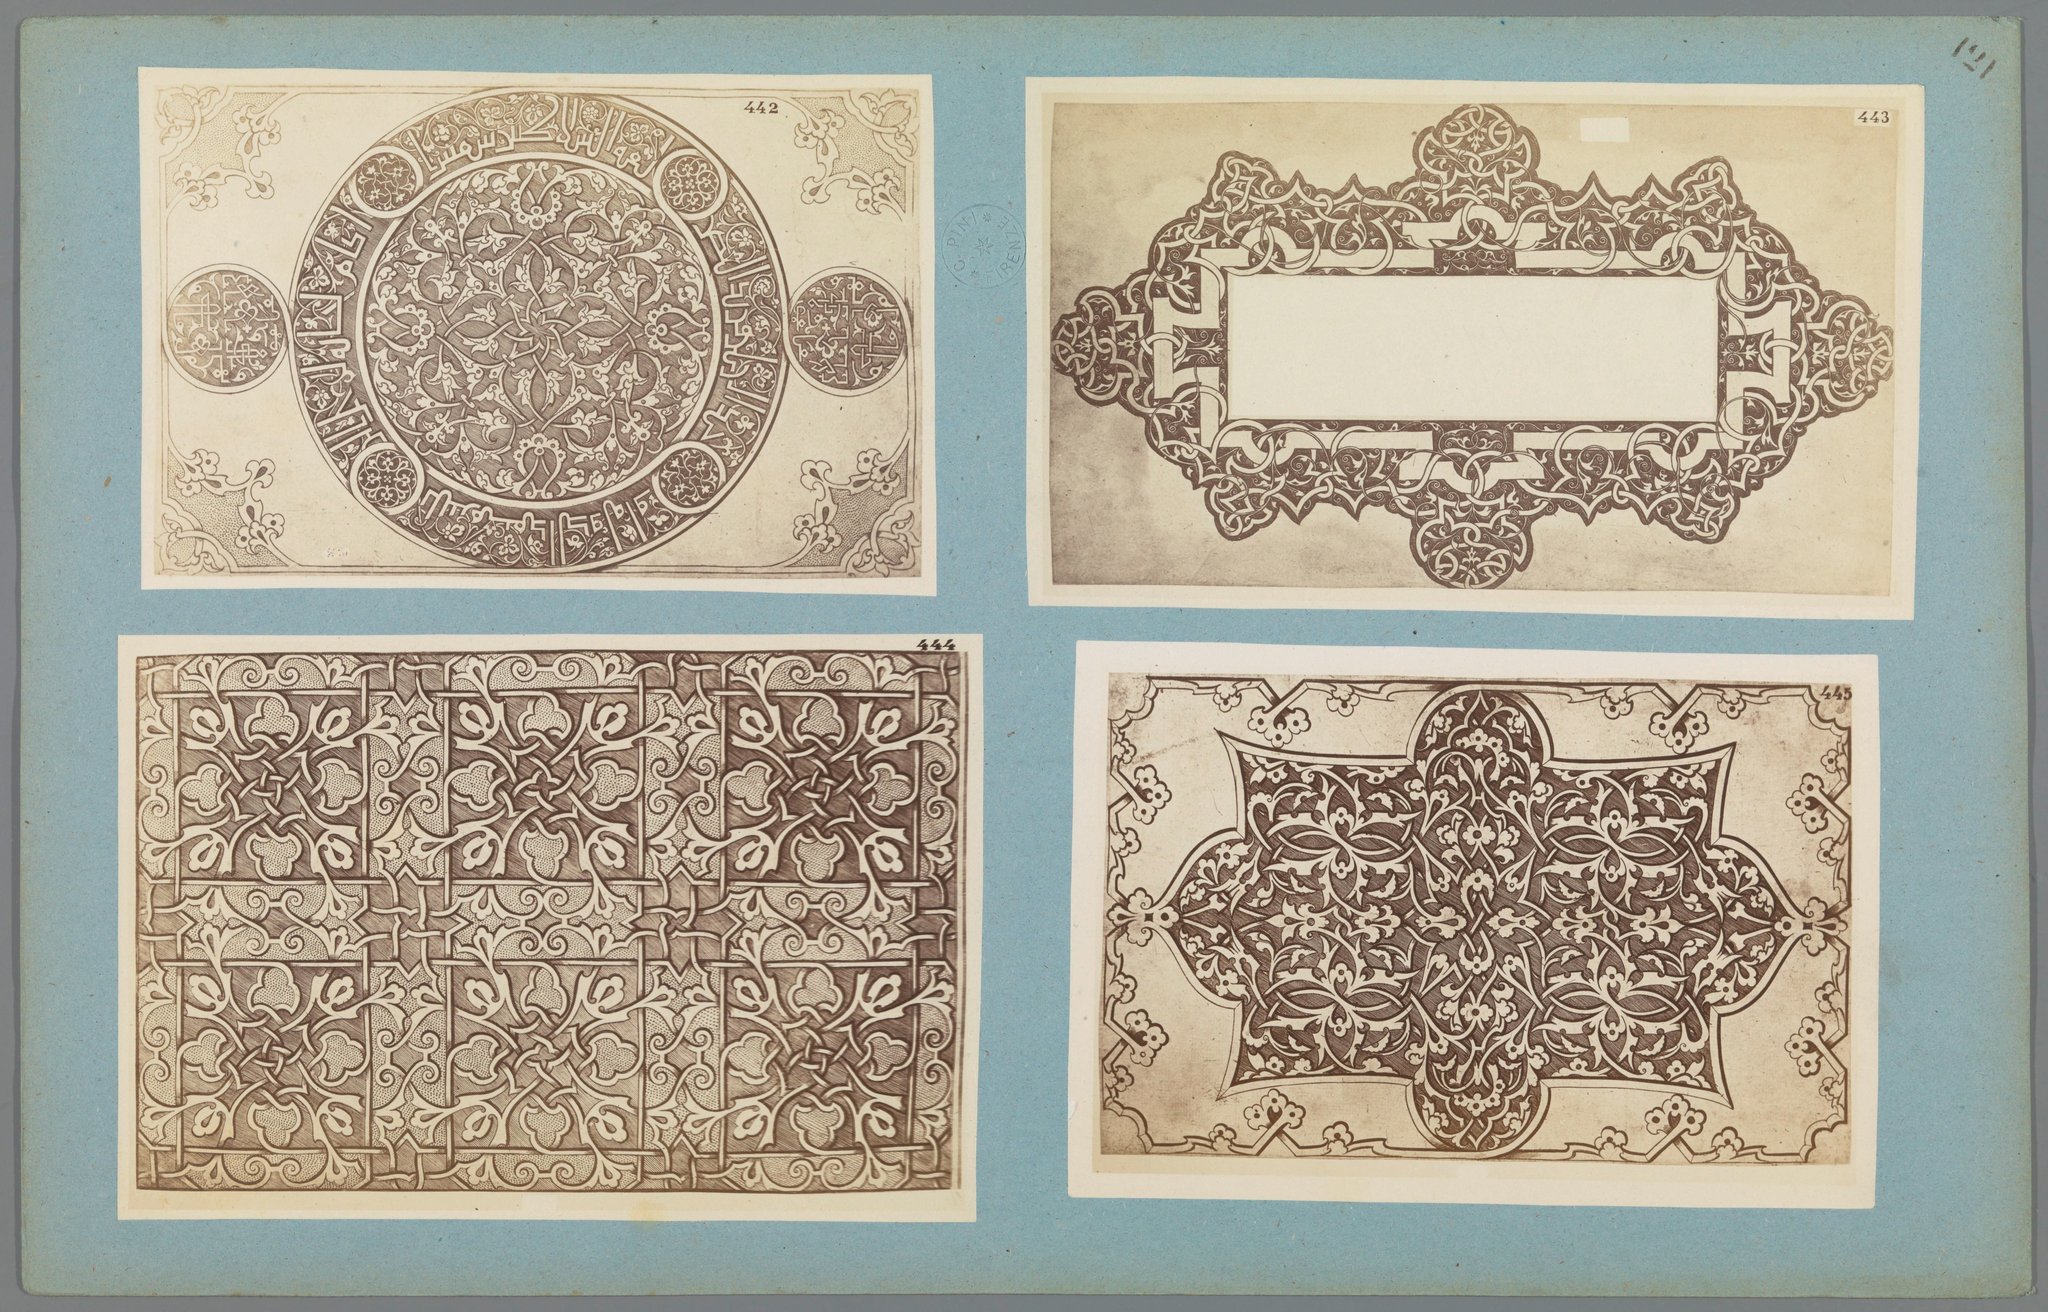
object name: photograph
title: Vier fotoreproducties van ornamentprenten met abstracte patronen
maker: Anonymous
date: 1875-1900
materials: cardboard, photographic support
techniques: albumen print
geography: europe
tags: foliage, tendrils, branches ~ ornament - aa - stylized, abstract interlace, knotwork ~ ornament, ornament ~ cartouche, europe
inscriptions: number: ‘443’, number: ‘455’, number: ‘121’, collector's mark: Lugt 3937, number: ‘442’, number: ‘444’, name: ‘C. PINI FIRENZE’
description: Linksboven (442) een prent van drie cirkels met abstracte patronen, linksonder (444) een prent van abstracte patronen, rechtsboven (443) een prent van een cartouche en abstracte patronen, rechtsonder (445) een prent van abstracte patronen.